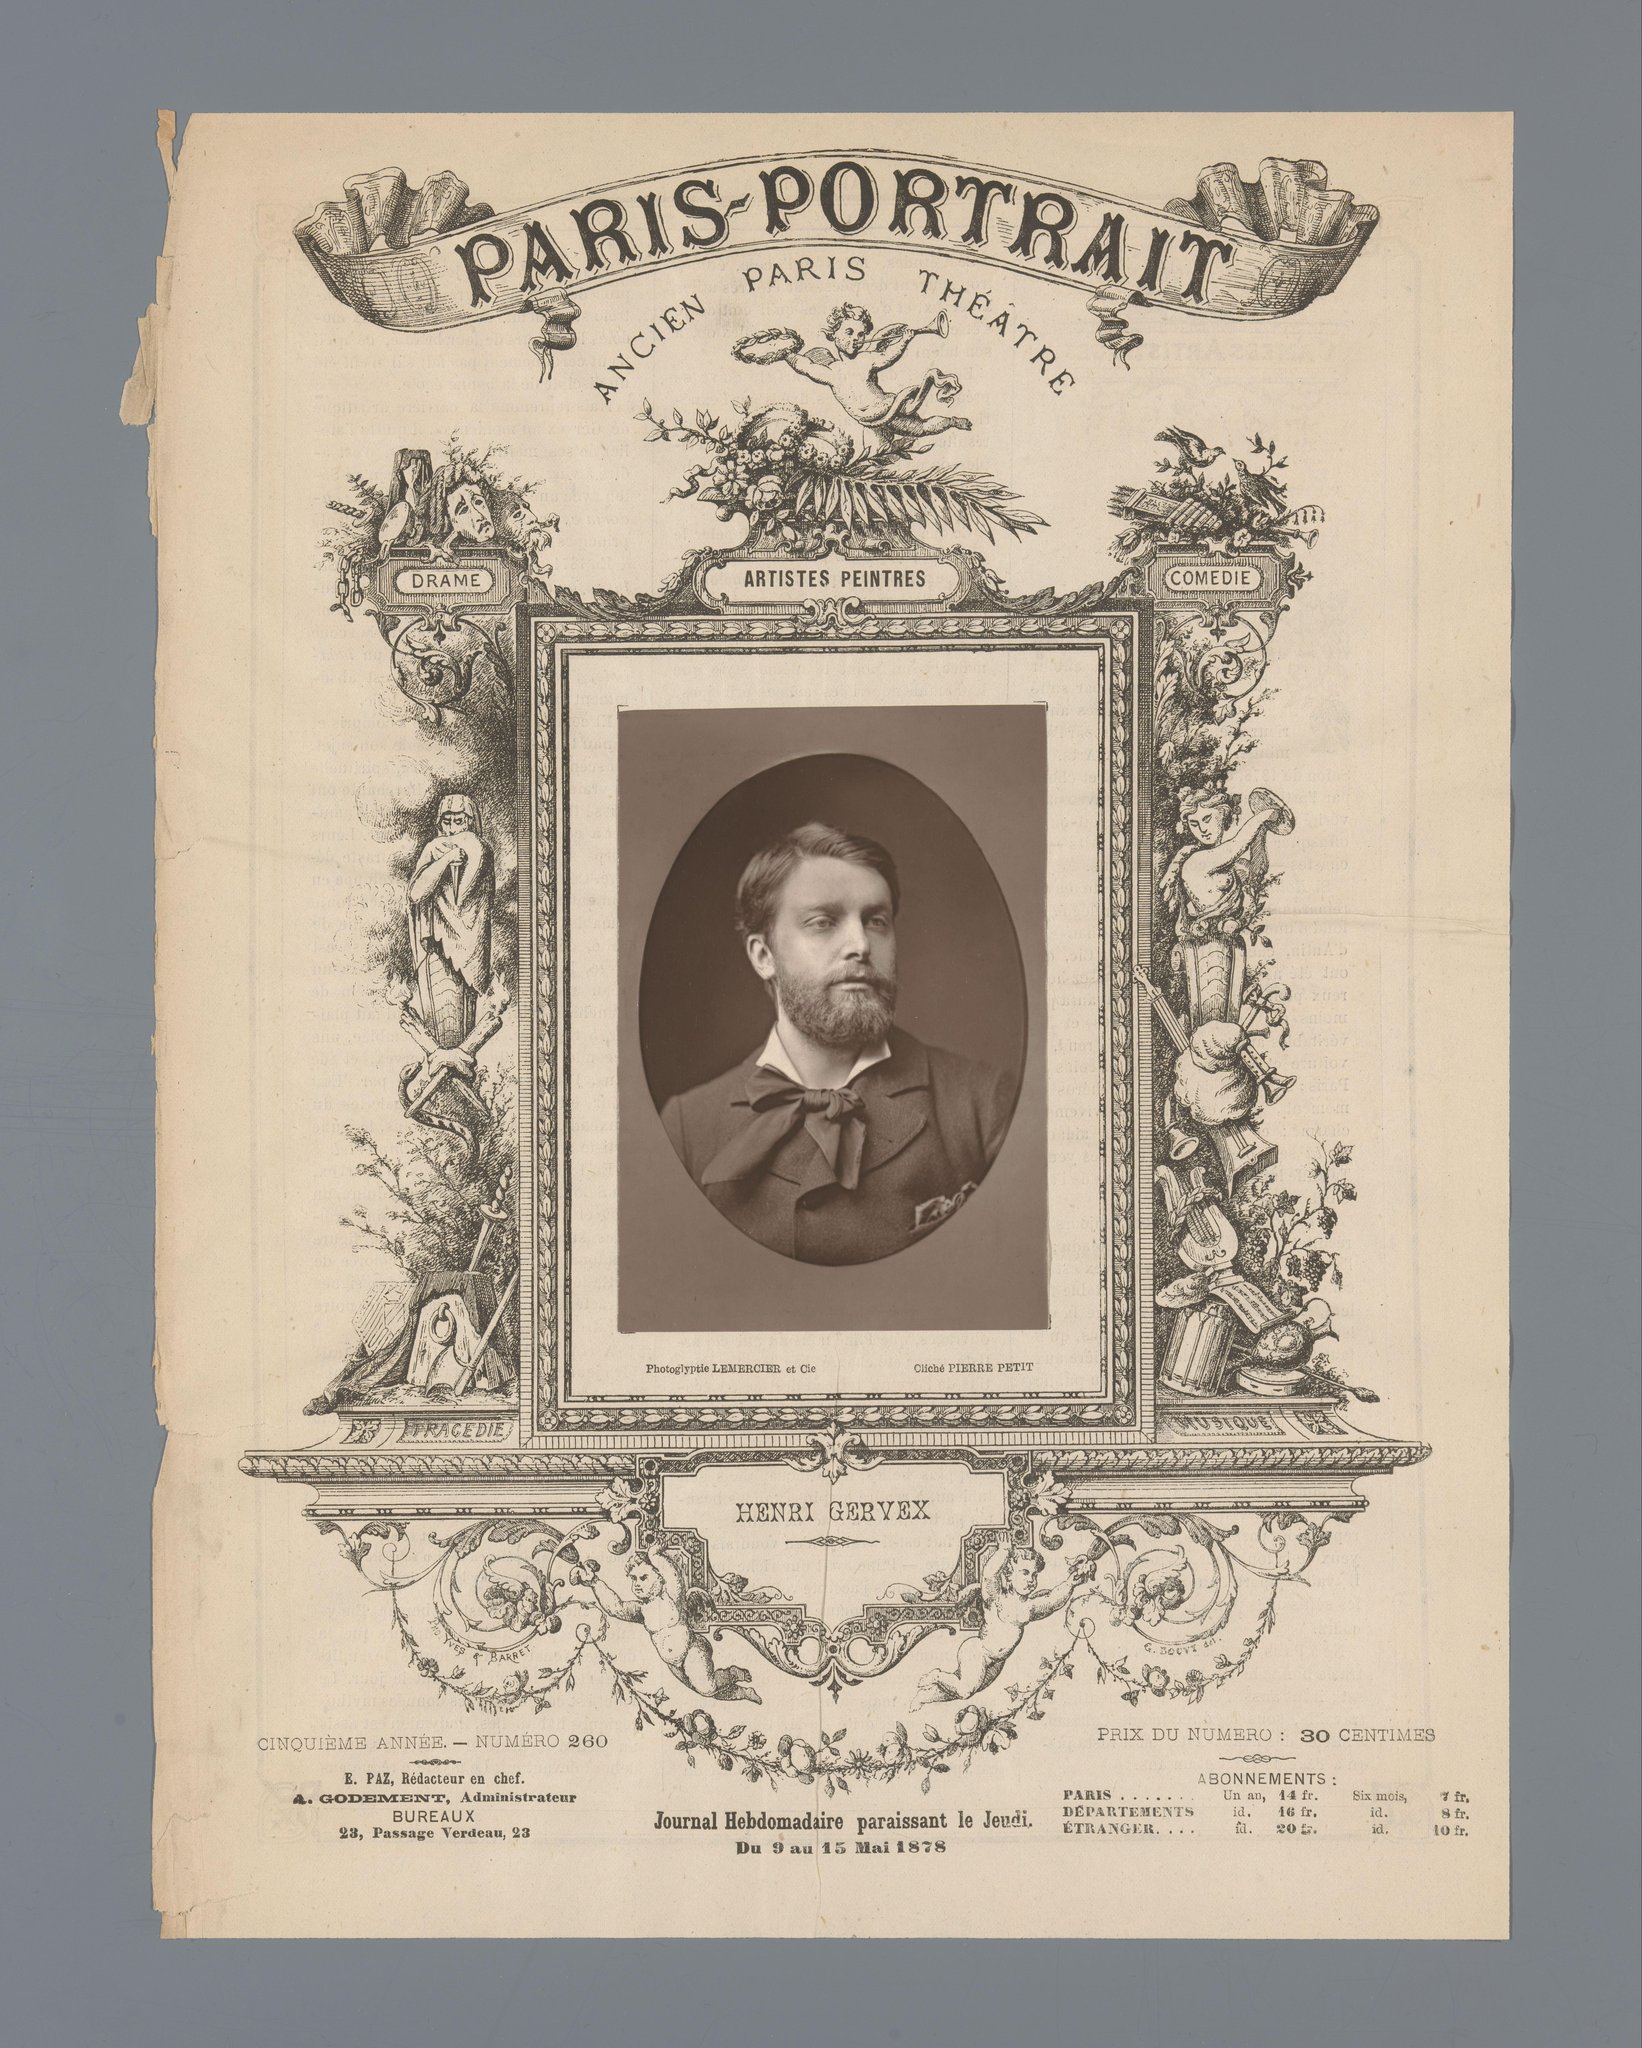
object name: photomechanical print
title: Portret van Henri Gervex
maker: pierre petit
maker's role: fotograaf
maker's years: 1832-1909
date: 1872-1879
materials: paper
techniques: woodburytype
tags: painter, henri gervex, historical persons